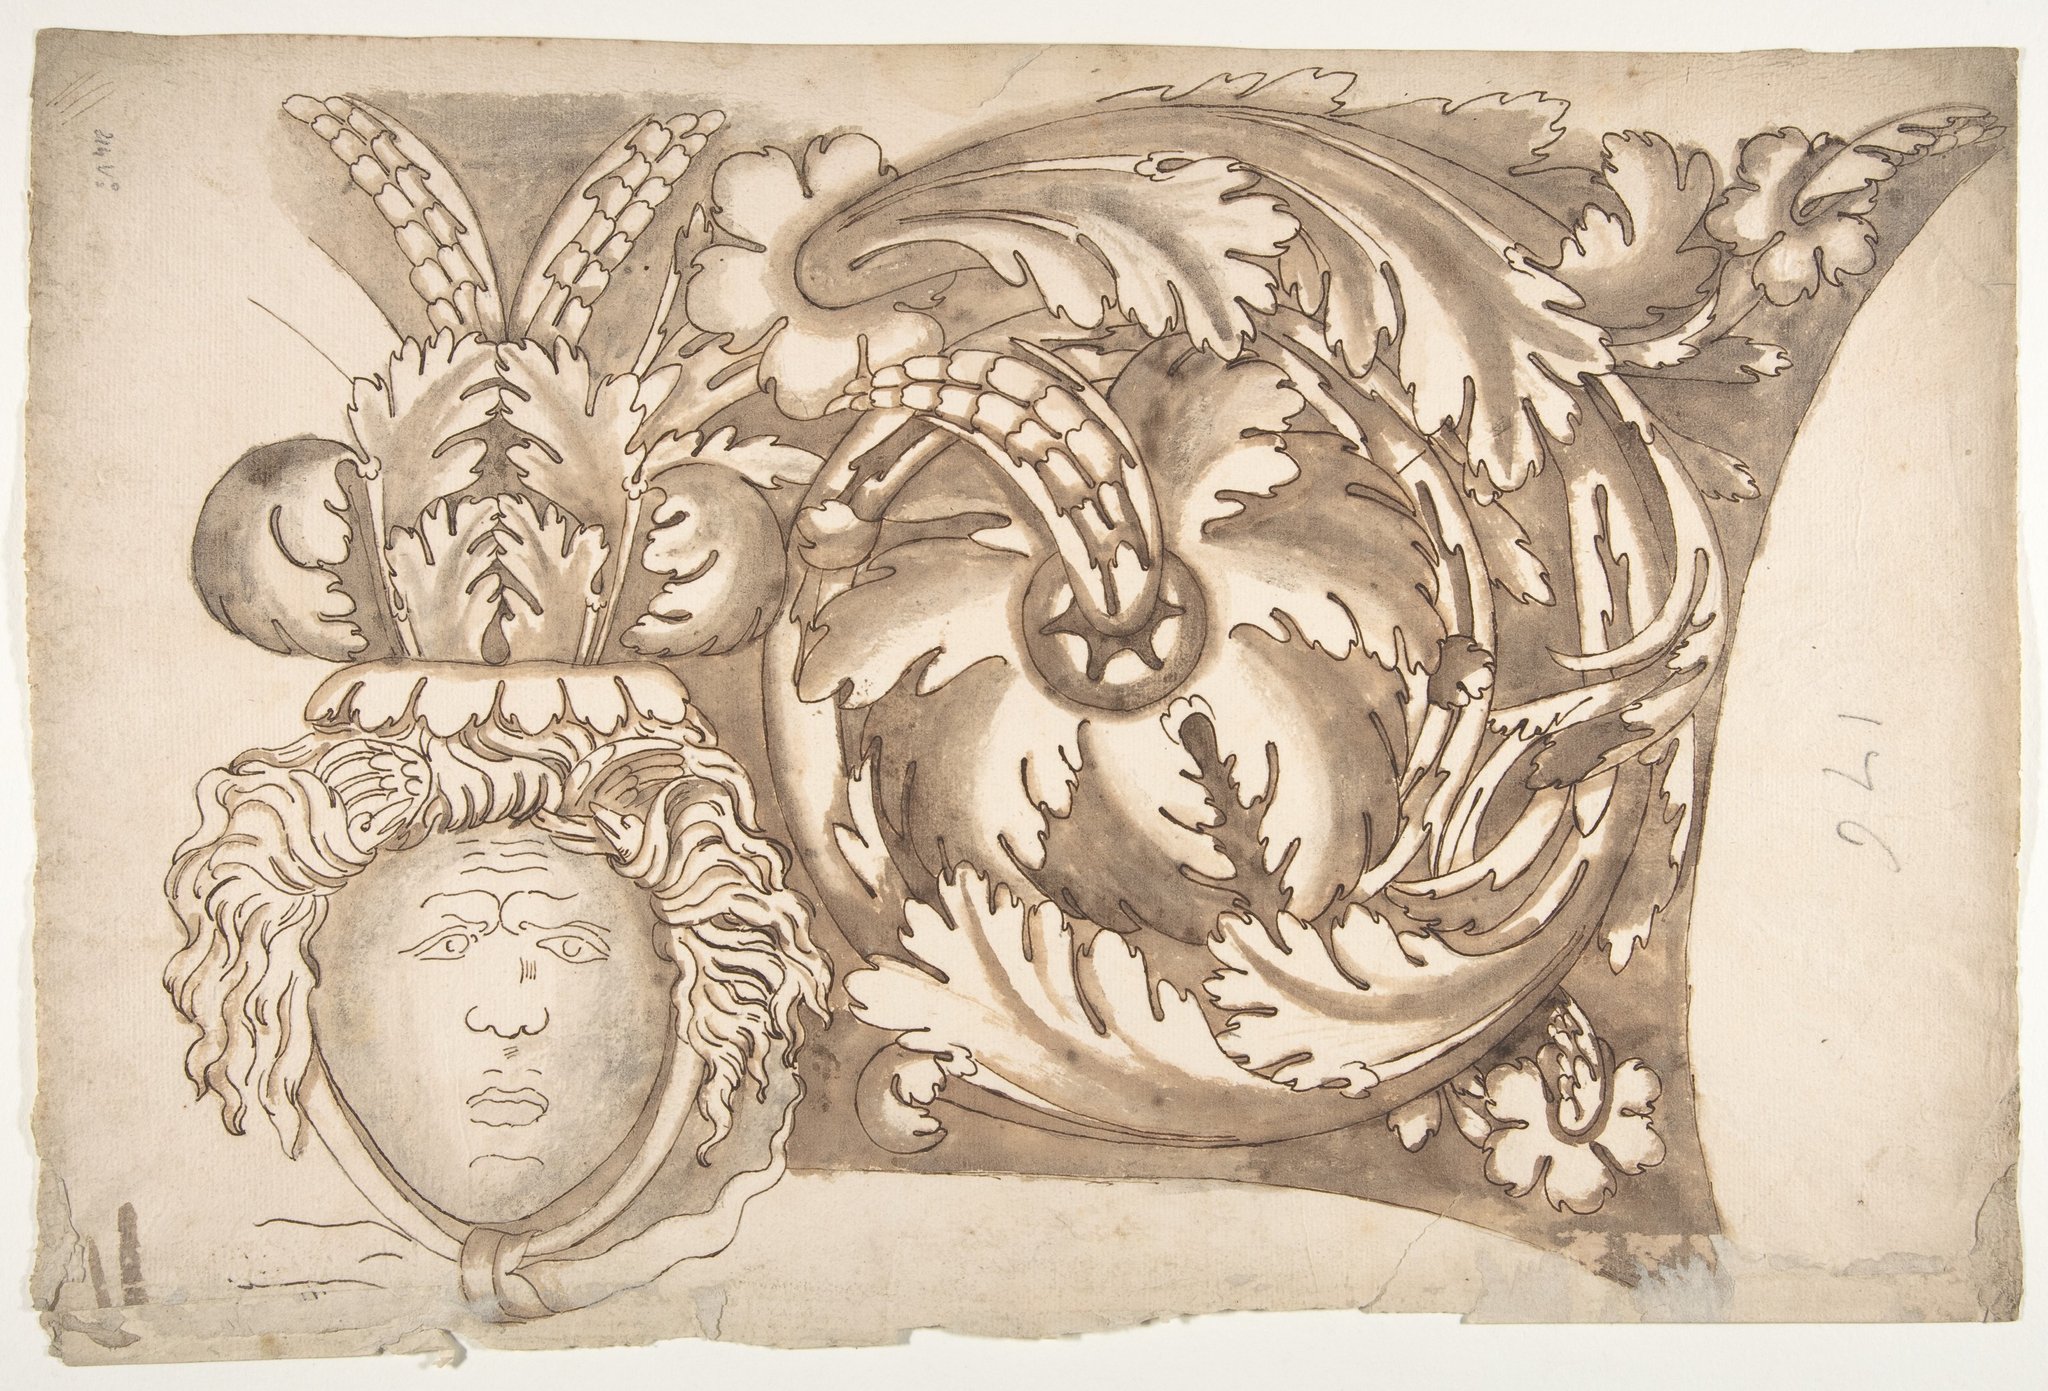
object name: collection ornament architecture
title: Arch of Septimius Severus, panel, elevation (recto) blank (verso)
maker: anonymous, french, 16th century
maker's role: draftsman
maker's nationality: french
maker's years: 1500-1600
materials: chalk, ink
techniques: incising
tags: ornament